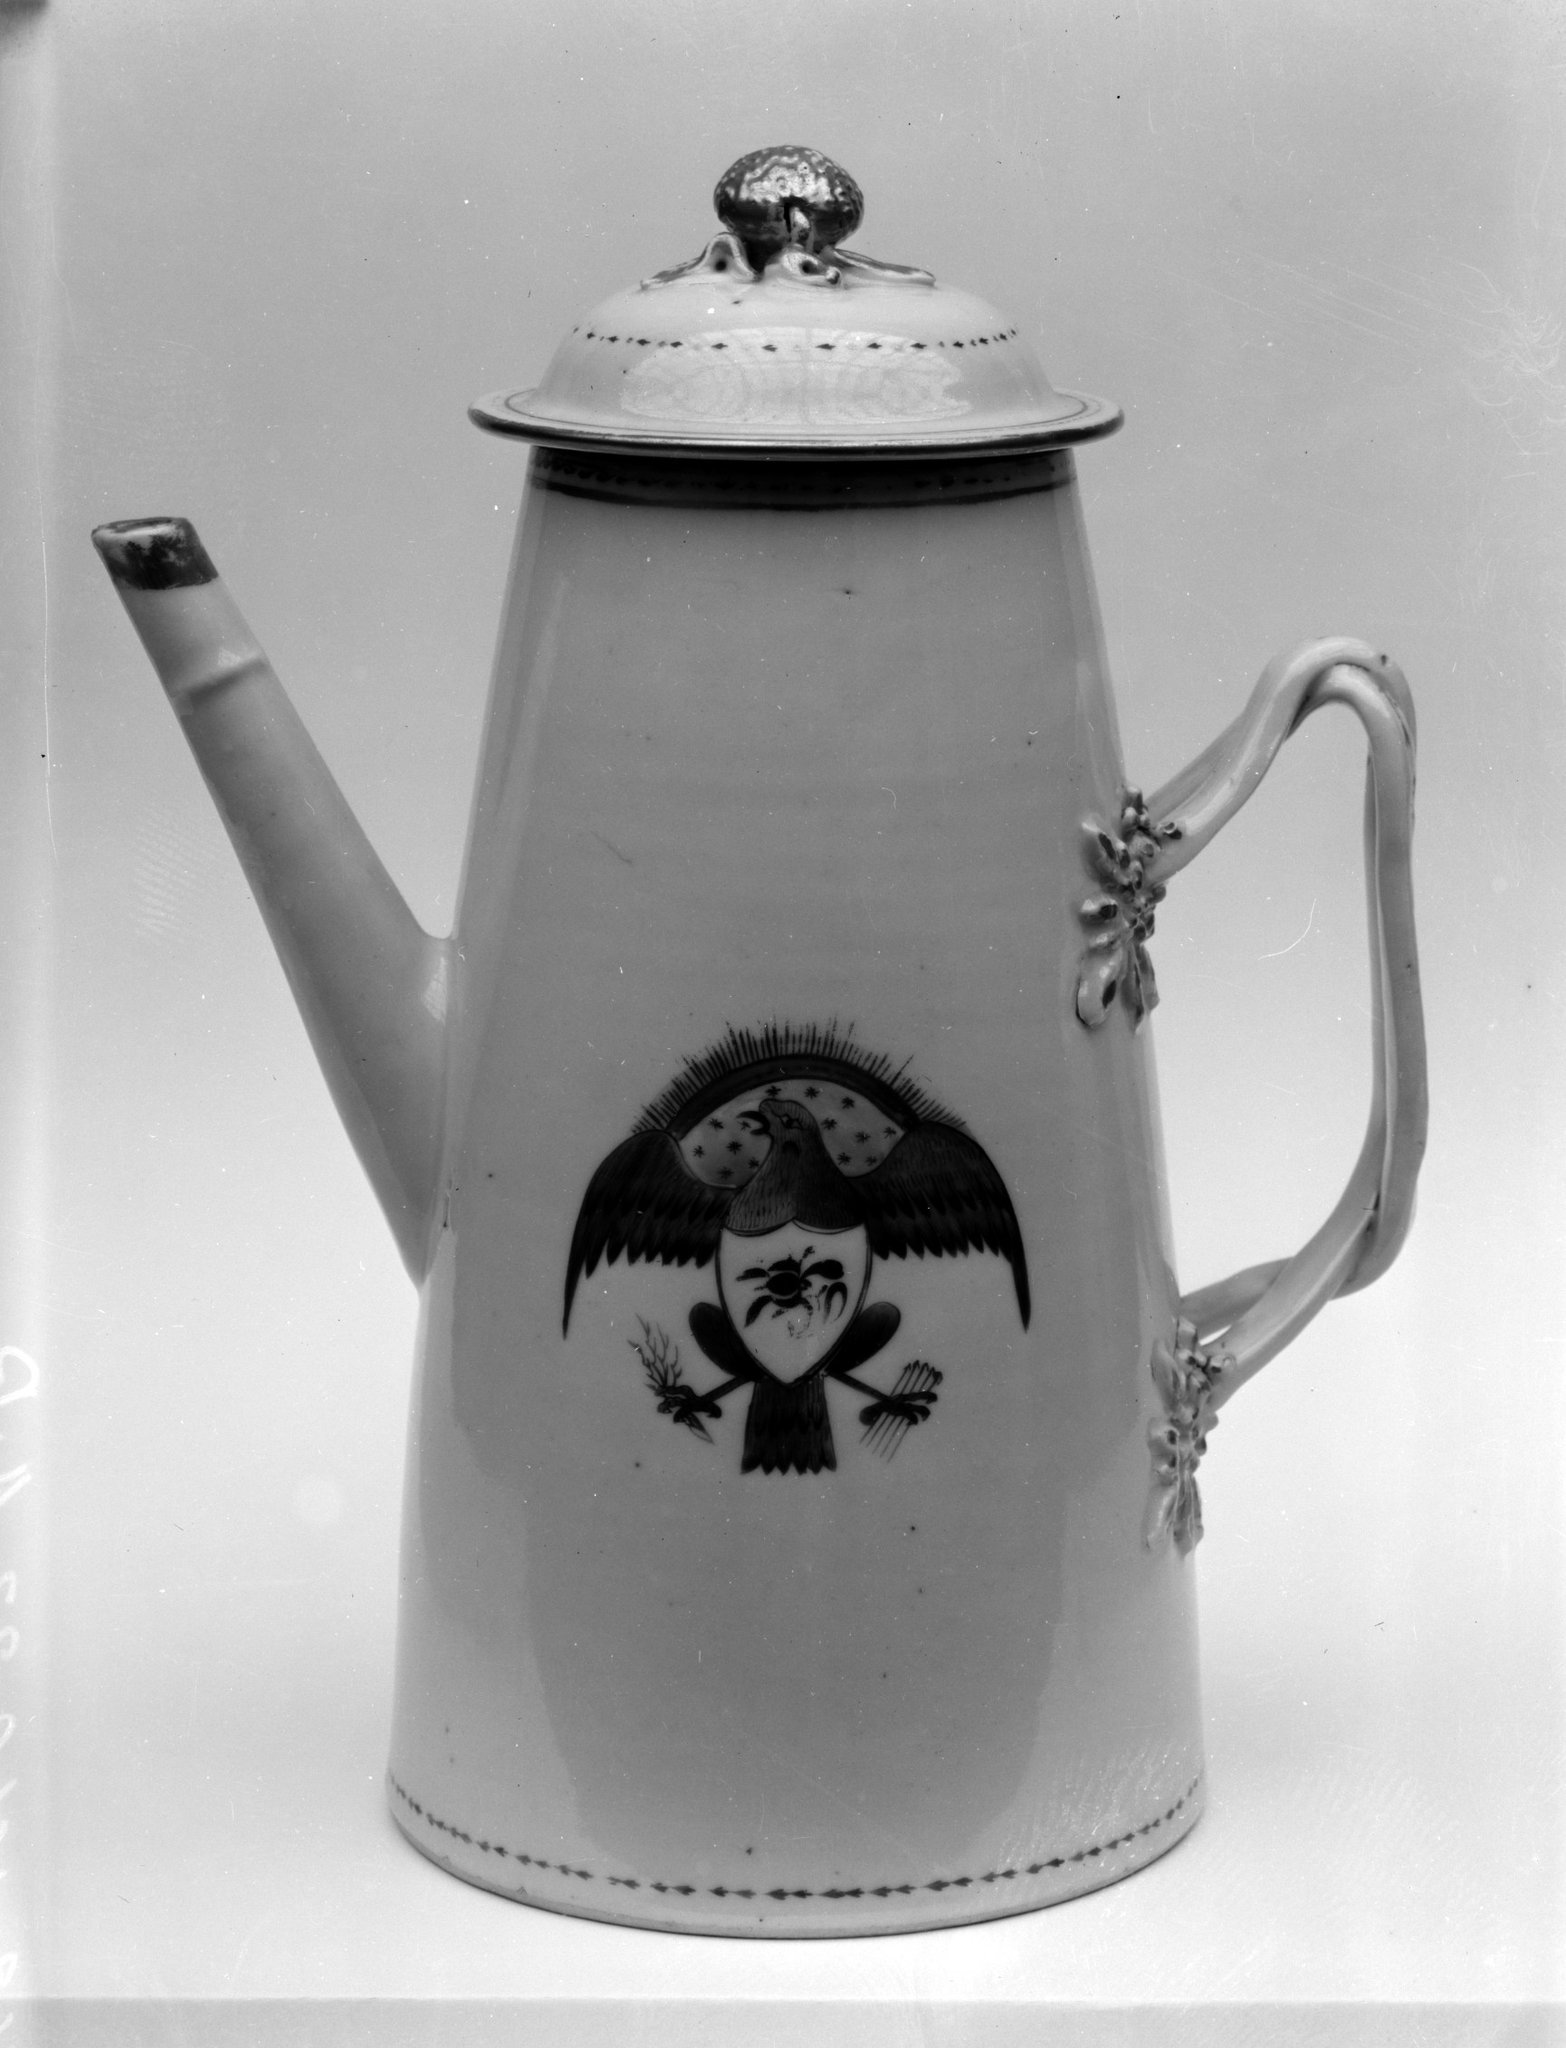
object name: coffeepot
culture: chinese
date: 1800-1815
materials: porcelain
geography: china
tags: eagles